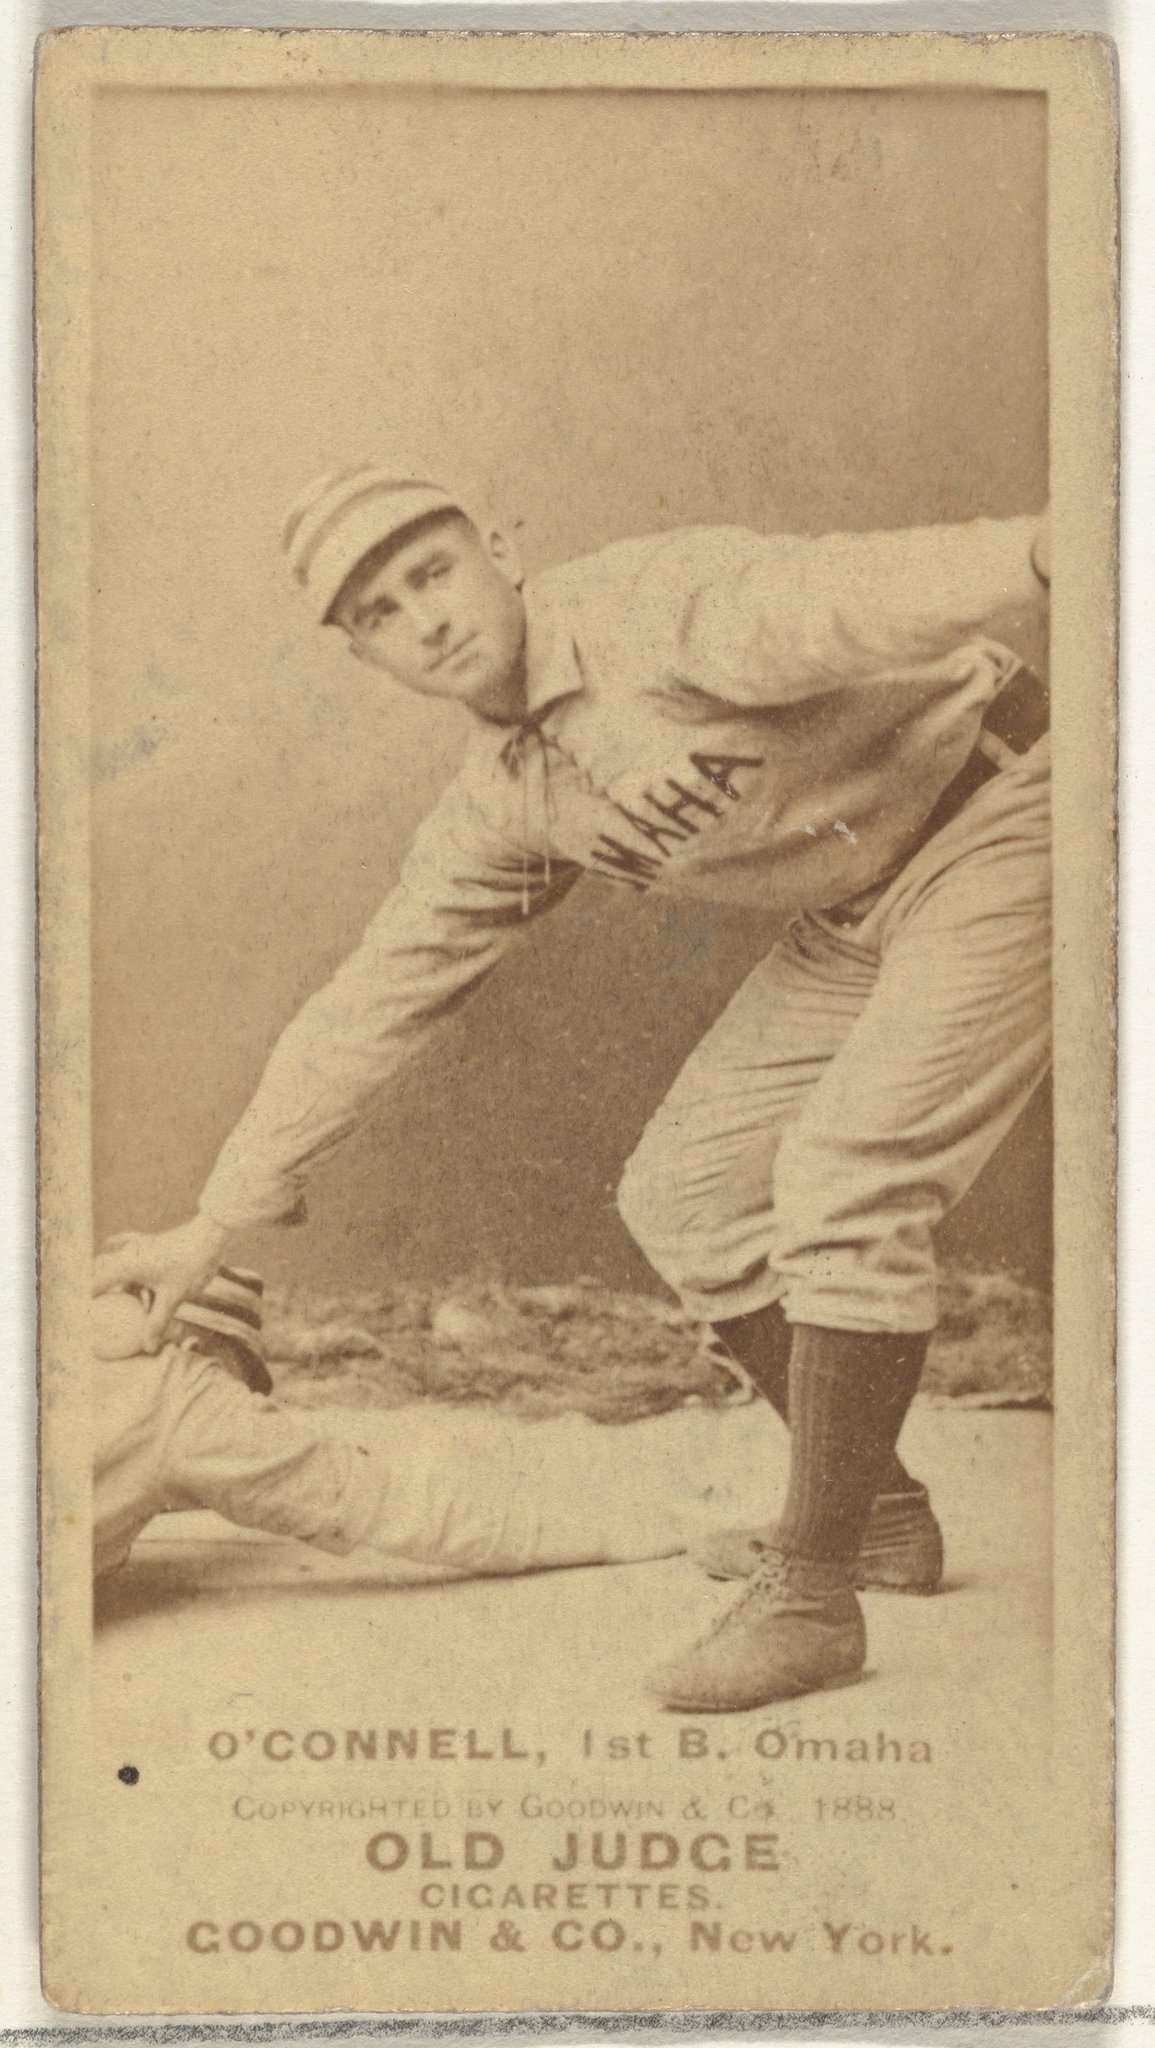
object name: baseball card, photograph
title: Patrick H. "Pat" O'Connell, 1st Base, Omaha Omahogs/ Lambs, from the Old Judge series (N172) for Old Judge Cigarettes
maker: goodwin & company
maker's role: publisher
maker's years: 1850-1950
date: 1888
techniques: albumen silver print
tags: men,portraits,baseball,athletes